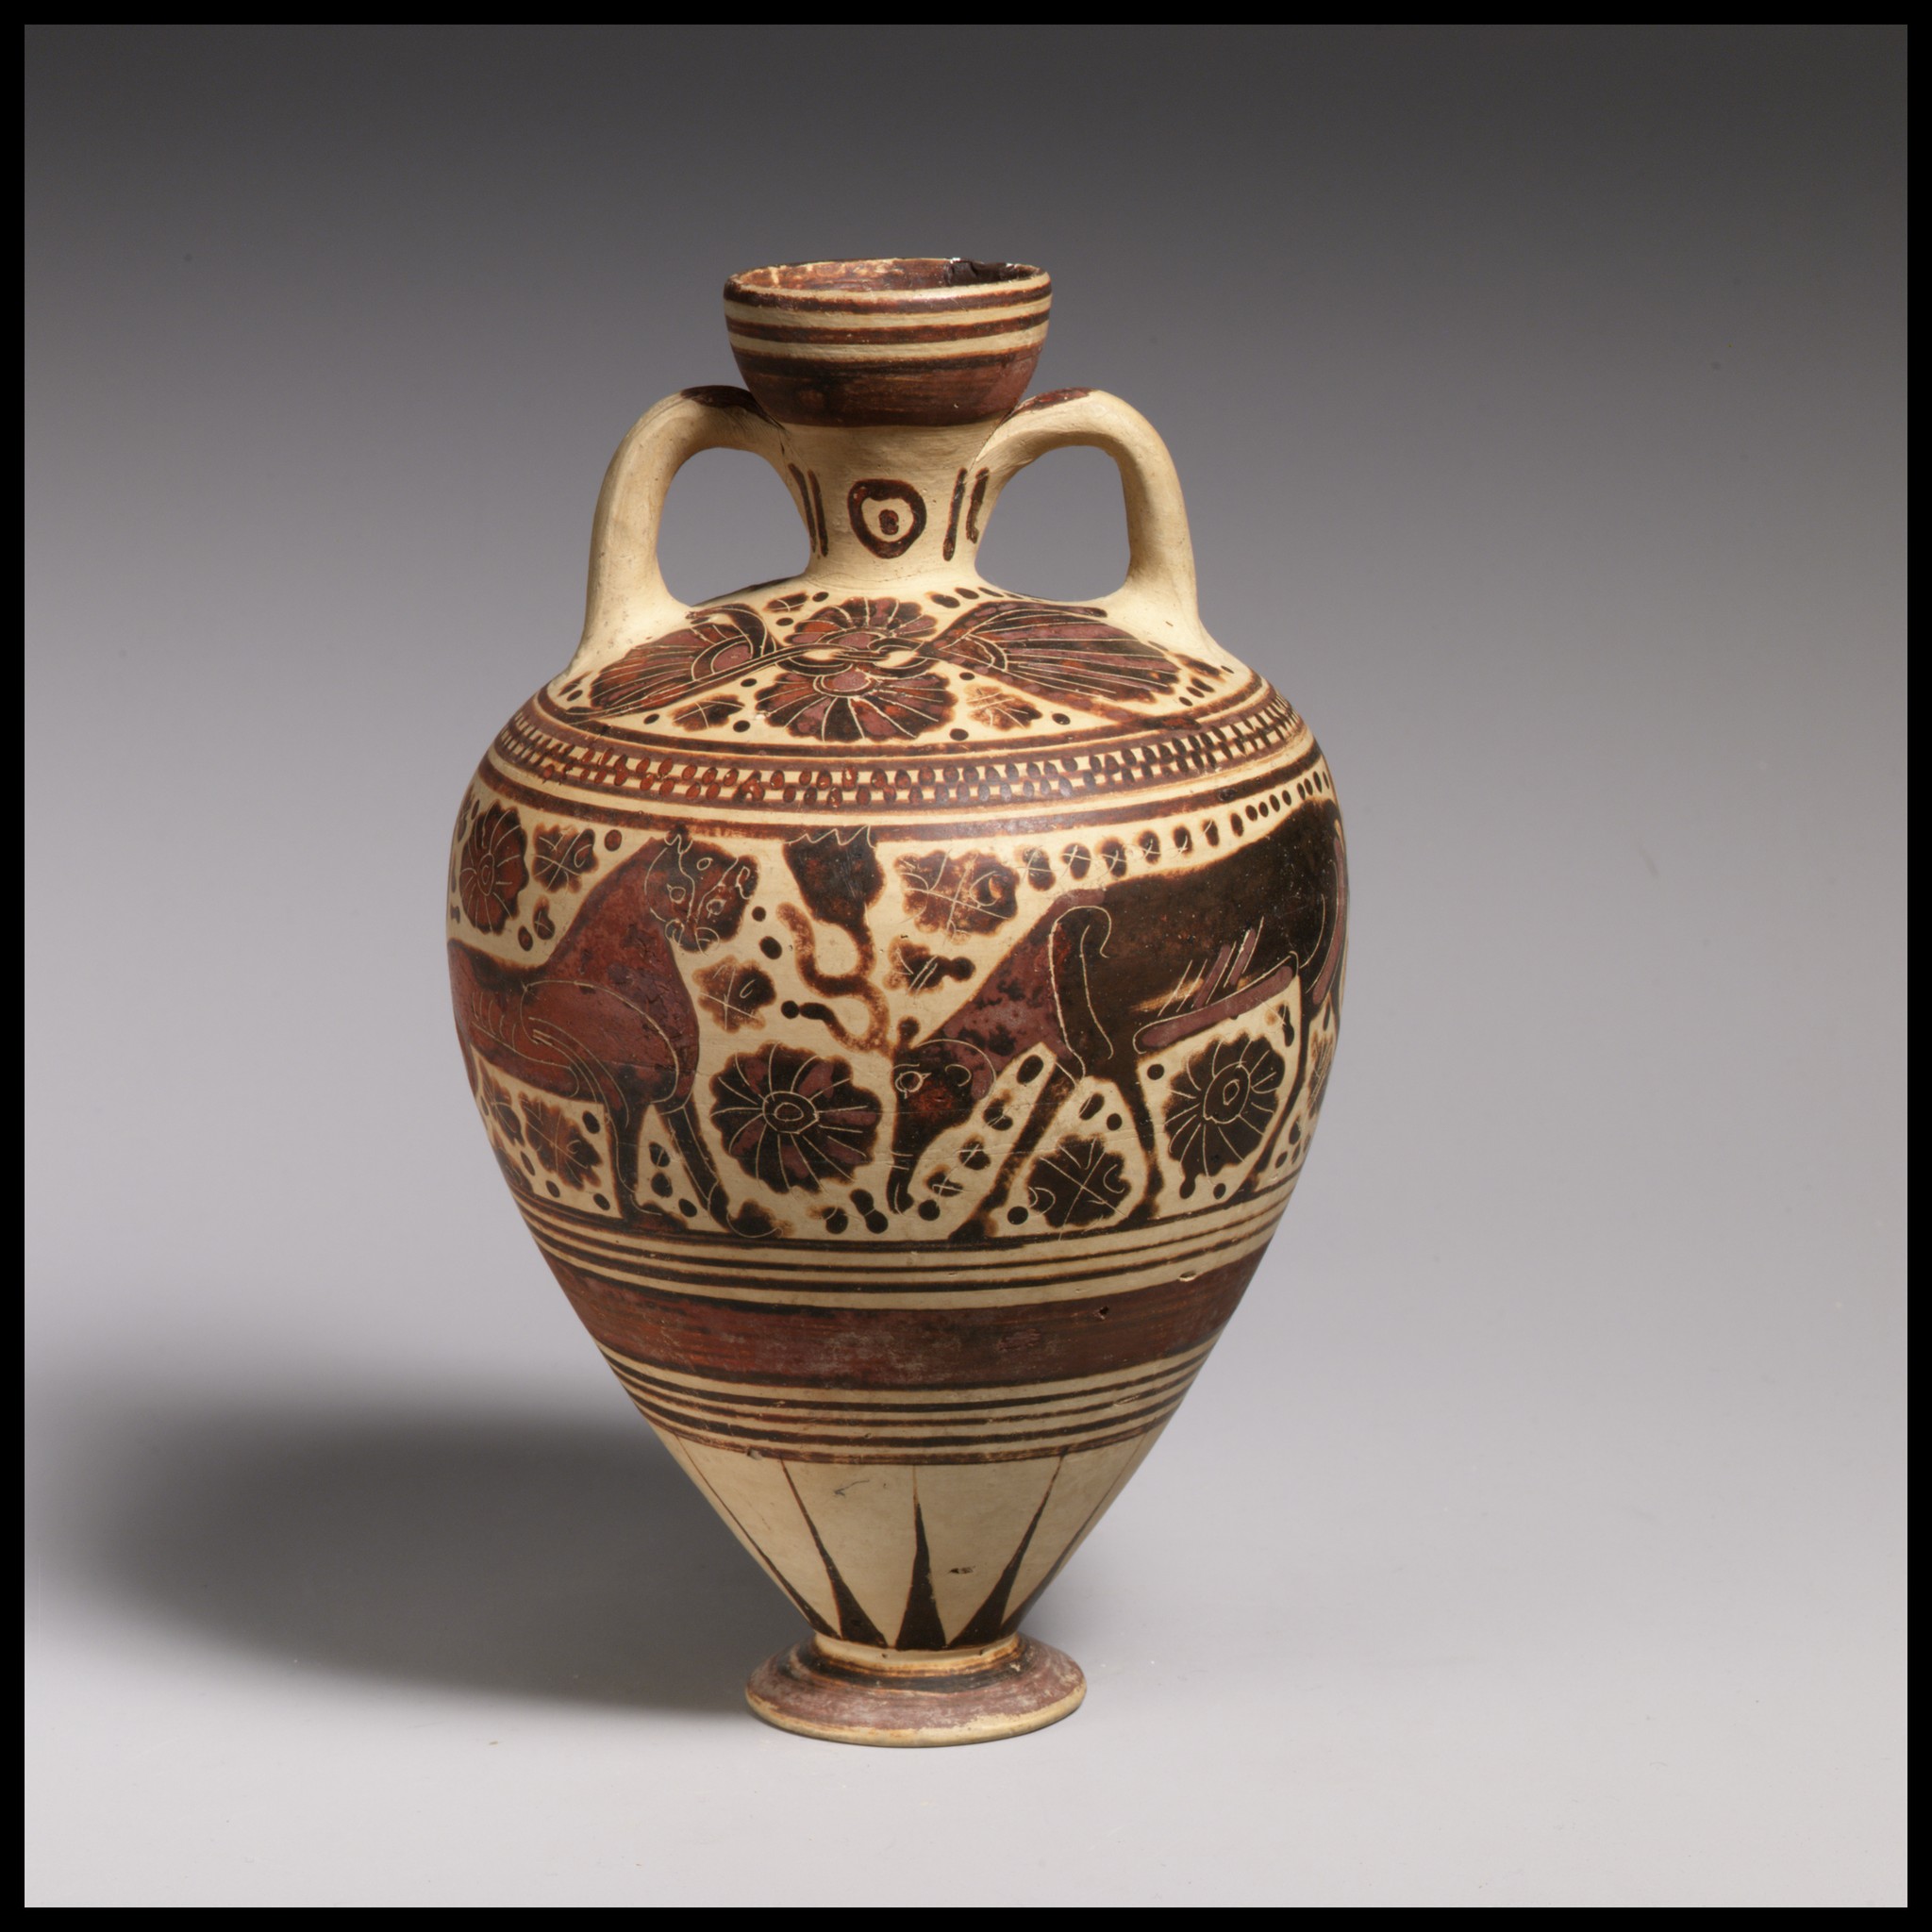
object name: amphoriskos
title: Terracotta amphoriskos (perfume vase)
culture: greek, corinthian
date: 575-550 BCE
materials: terracotta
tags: deer,panthers